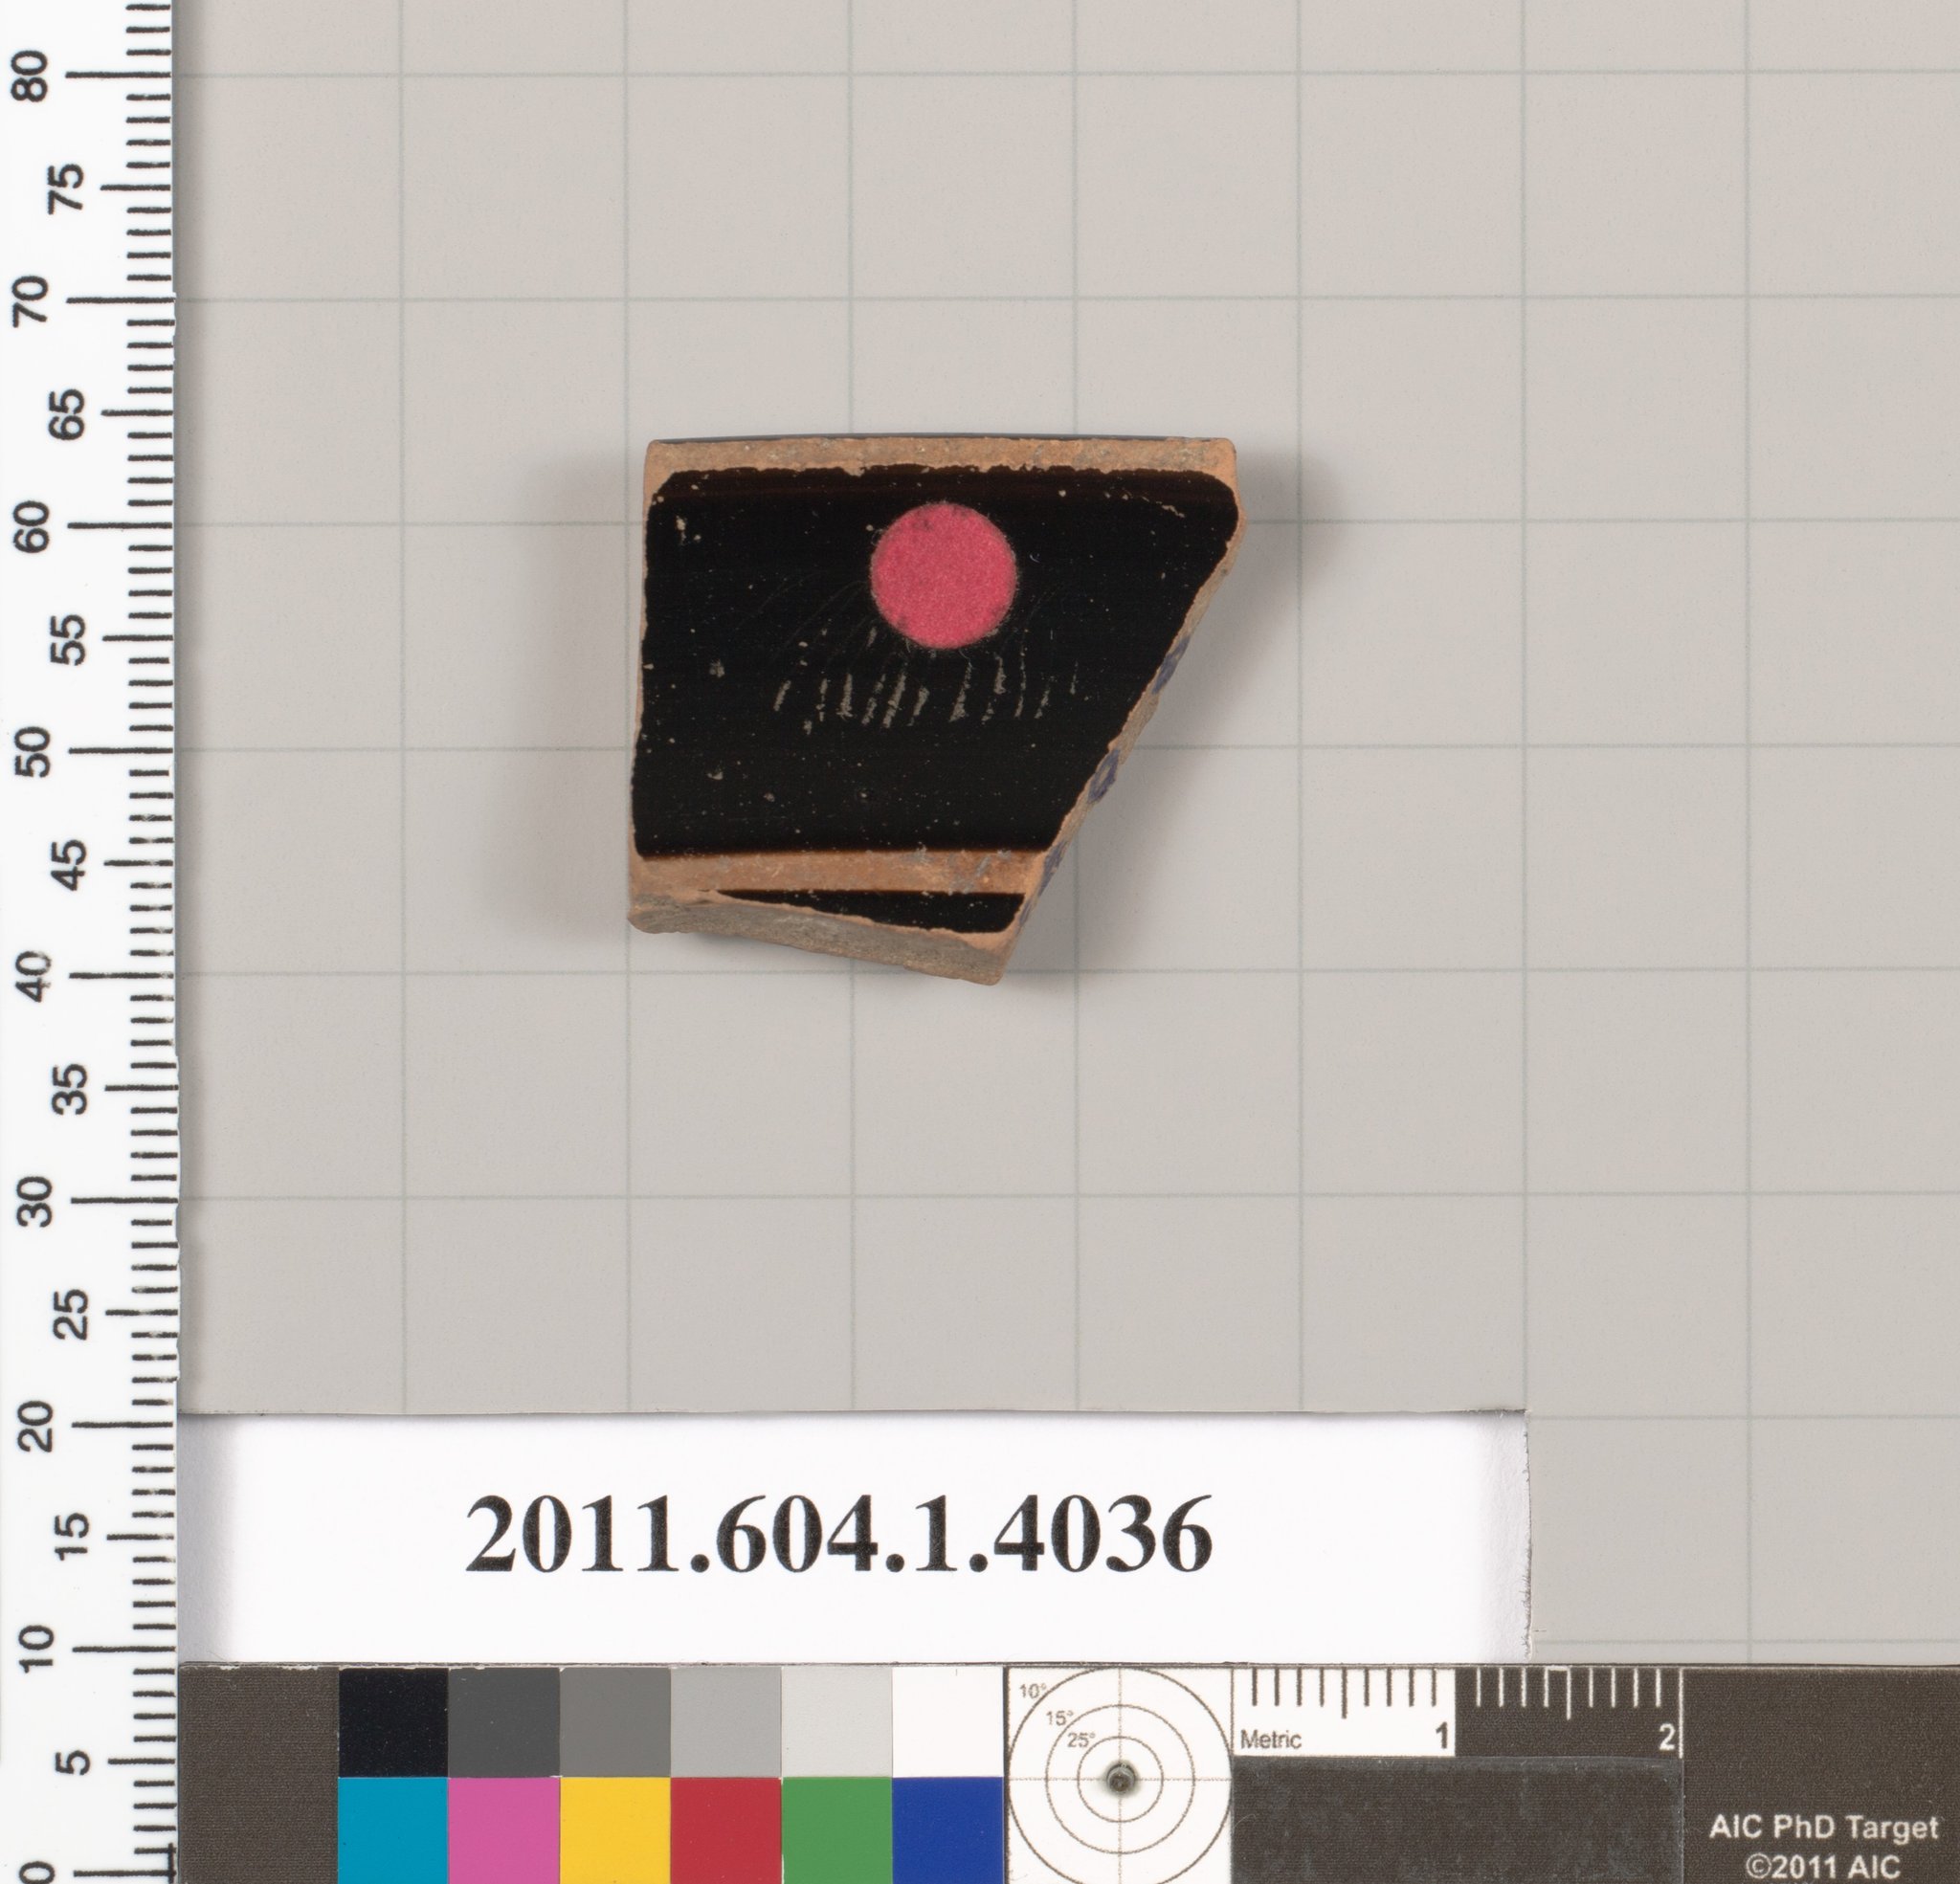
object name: kylix fragment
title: Terracotta rim fragment of a kylix (drinking cup)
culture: greek, attic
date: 460-440 BCE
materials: terracotta